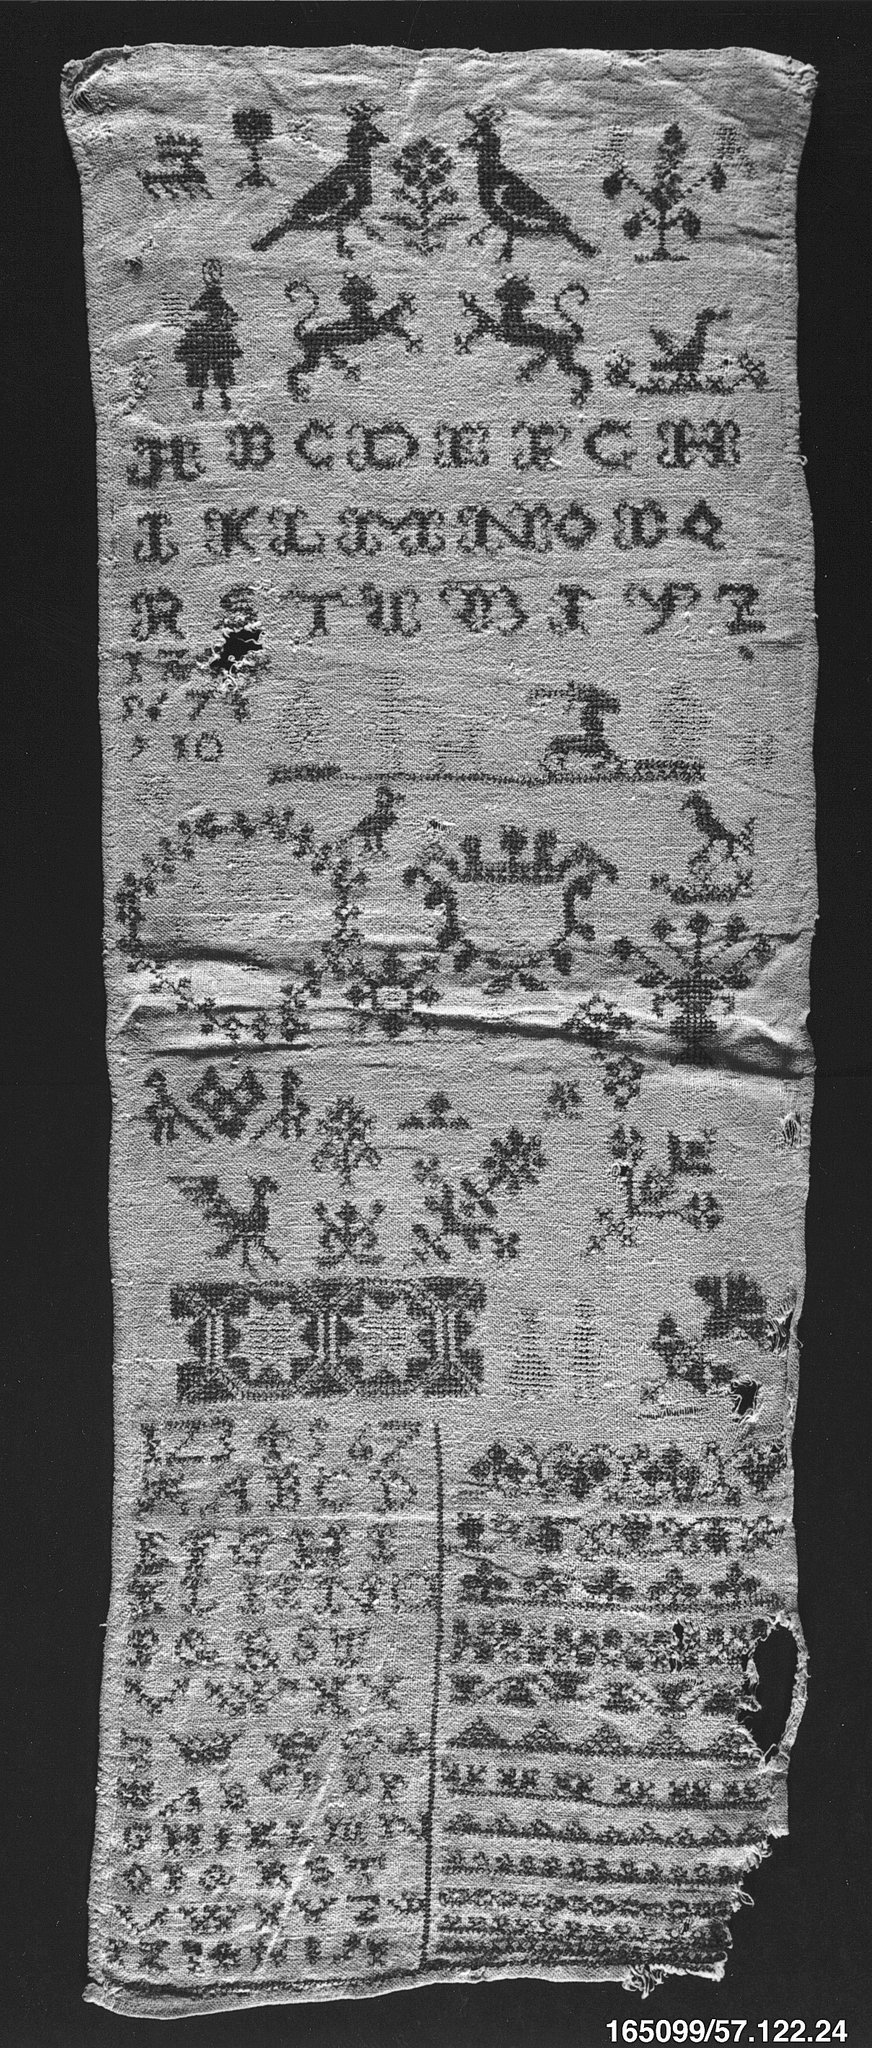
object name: sampler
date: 1764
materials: cotton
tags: birds,deer,flowers